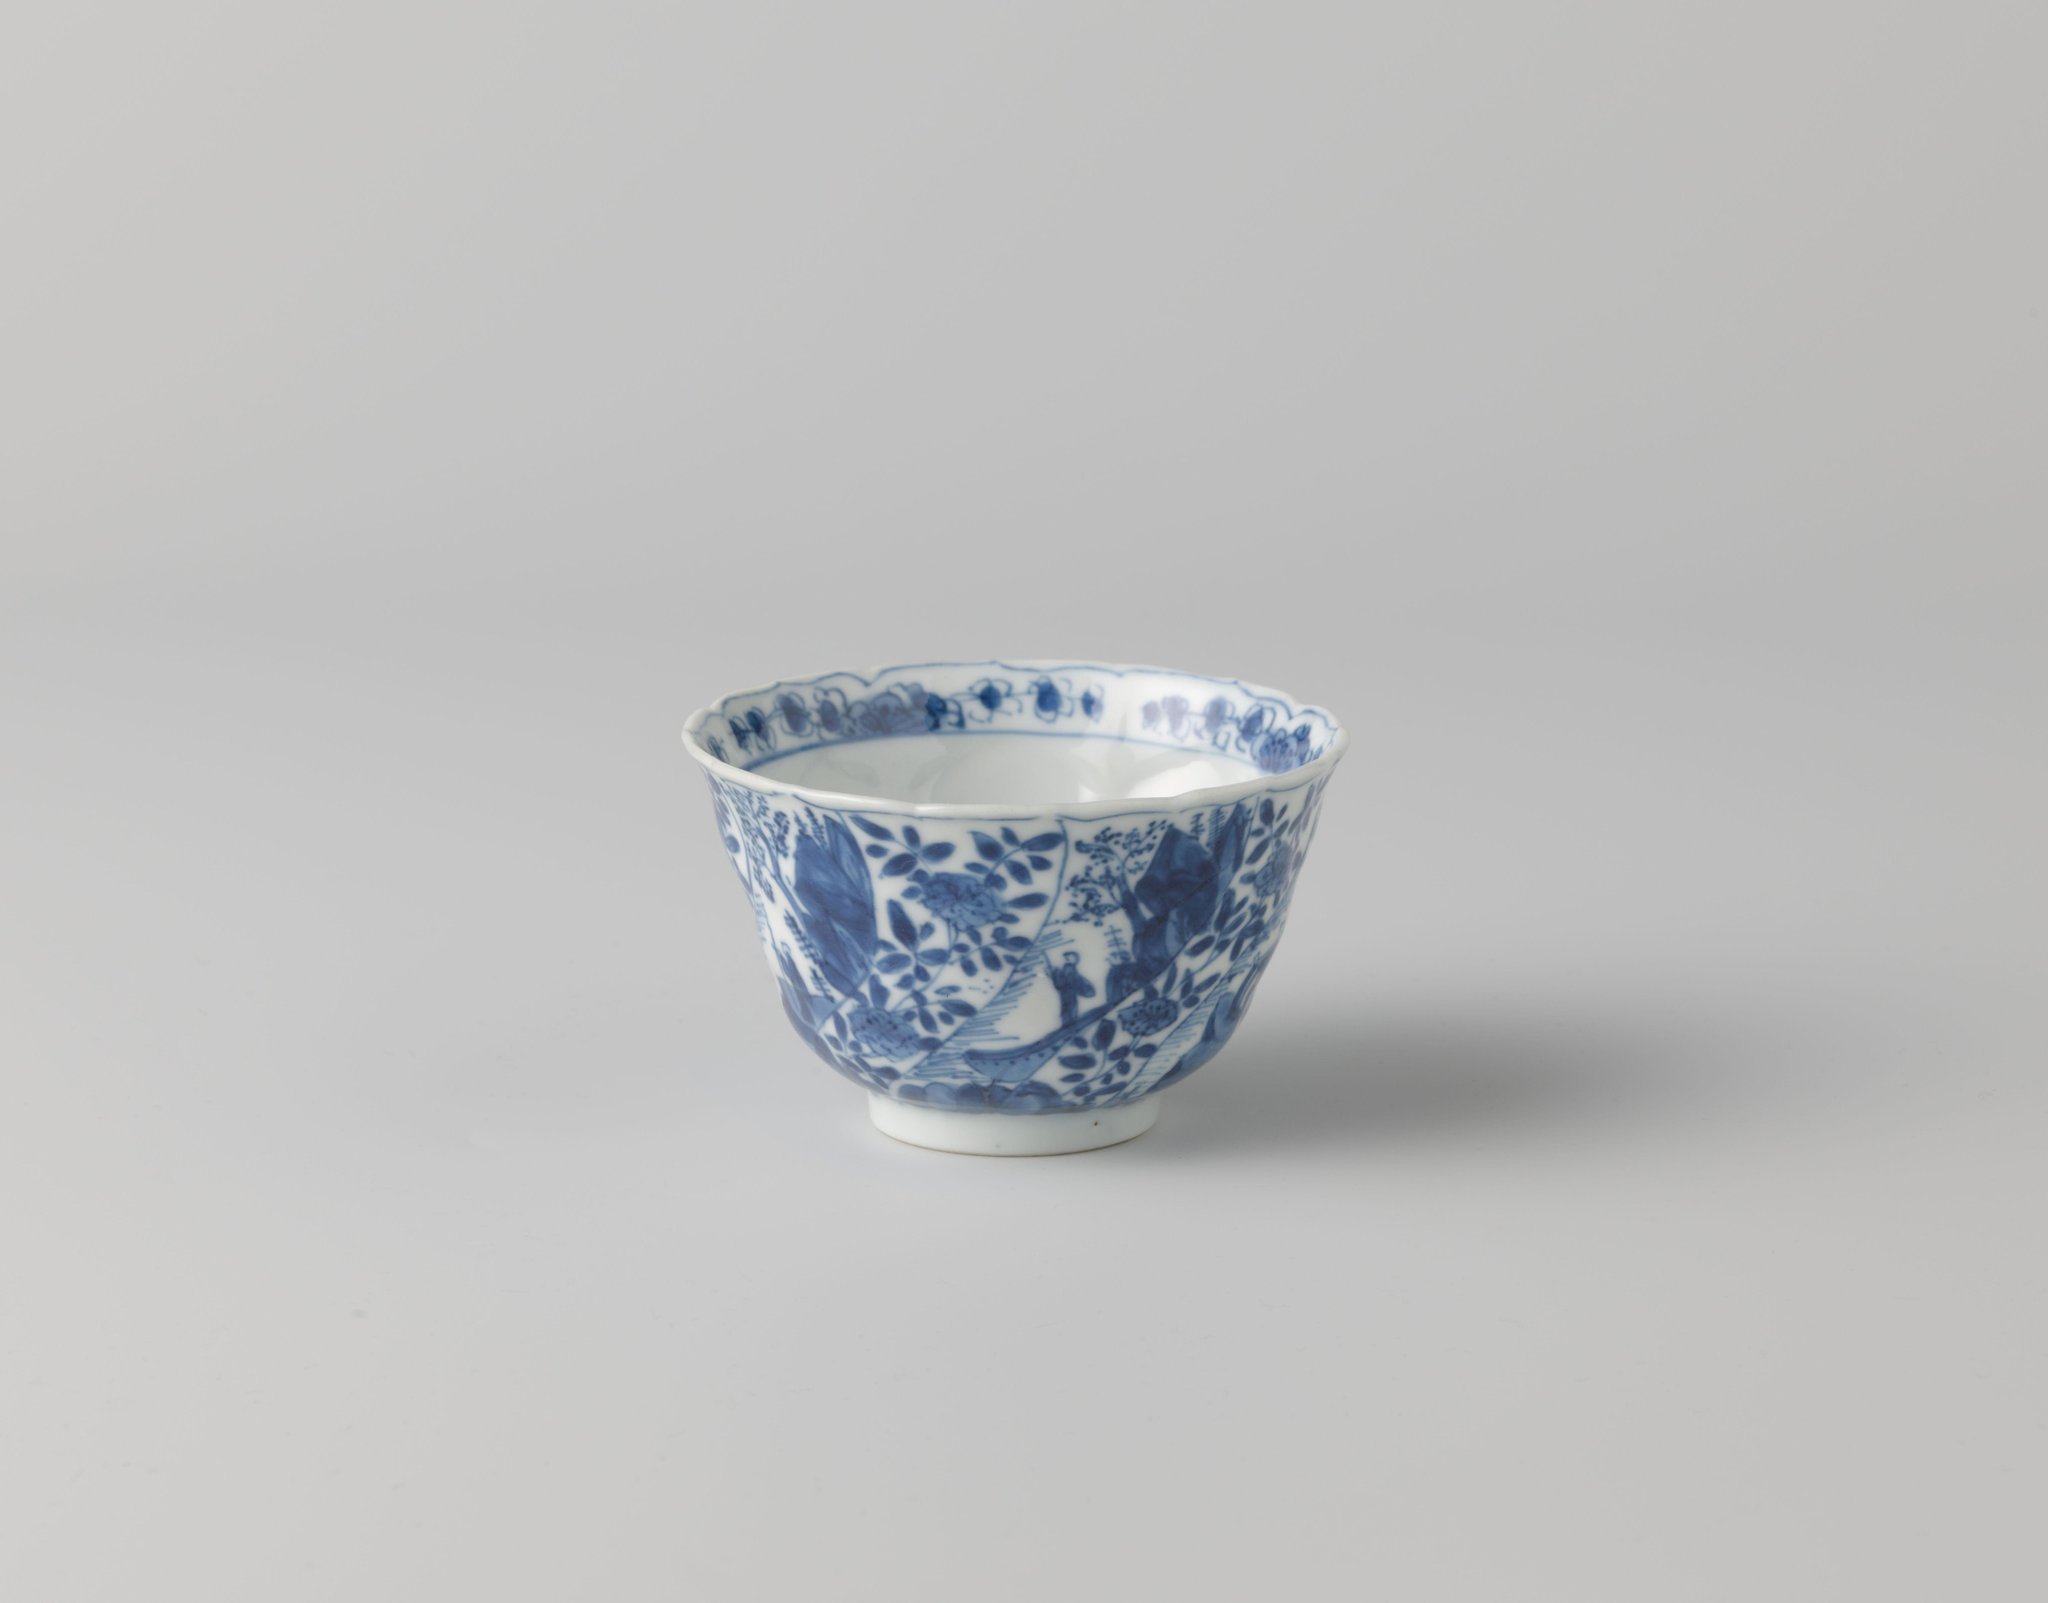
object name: cup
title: Cup with twisted panels with landscape or flower spray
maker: Anonymous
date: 1700-1724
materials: cobalt, glaze, paint, porcelain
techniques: firing, turning, vitrification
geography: china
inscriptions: mark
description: Kop en schotel met bergachtige landschappen en wilde rozen